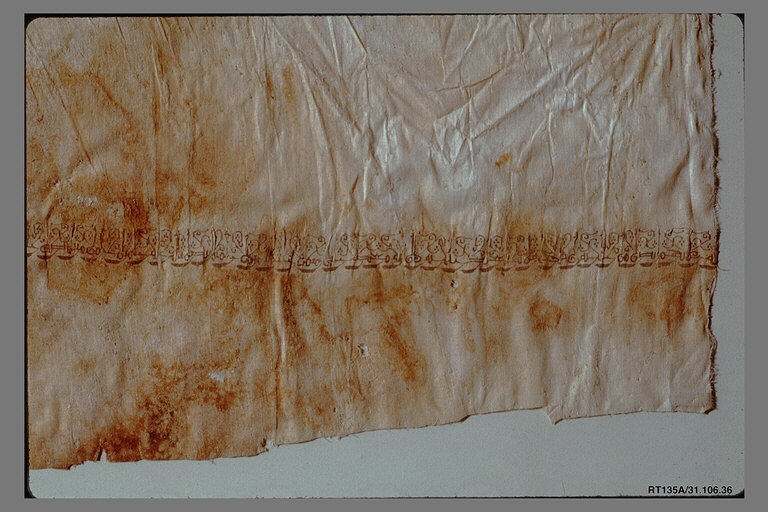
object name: textile fragment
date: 1035-1094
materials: linen, silk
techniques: weave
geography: egypt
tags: arabic